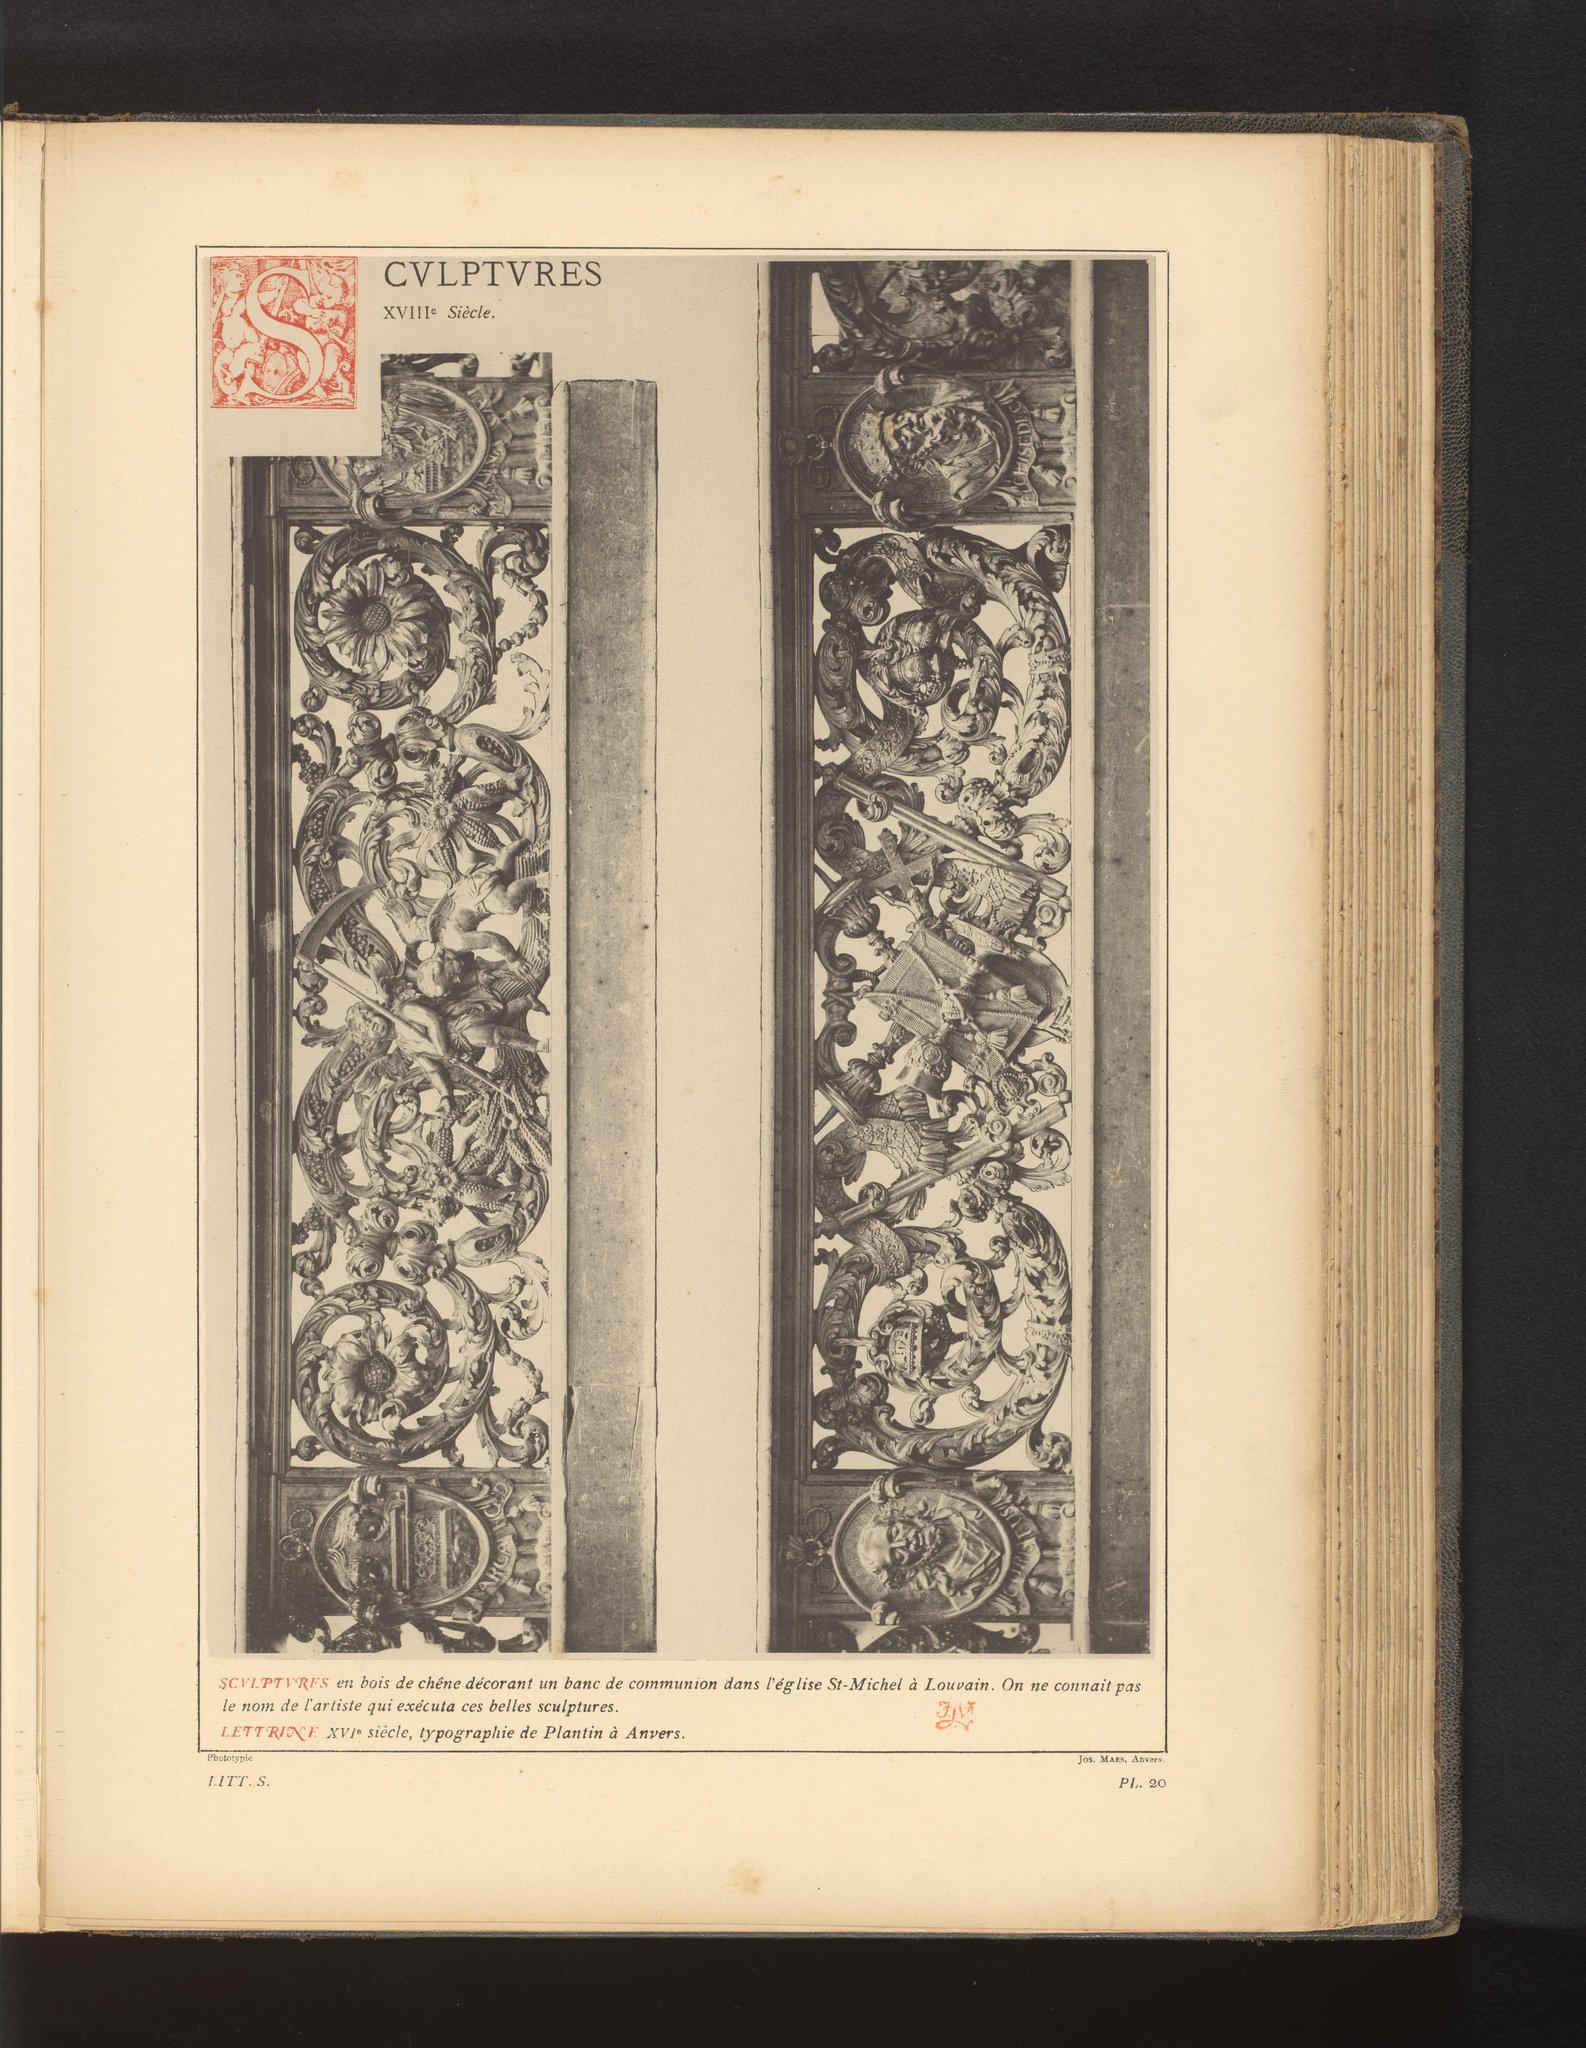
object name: page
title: Sculptures, XVIIIe Siècle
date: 1876-1881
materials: paper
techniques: photograph, photolithography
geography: antwerp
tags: sculpture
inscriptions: inscription: ‘SCULPTURES en bois de chêne (...)’, monogram: ‘JJvY’, inscription: ‘LITT. S. - PL. 20.’